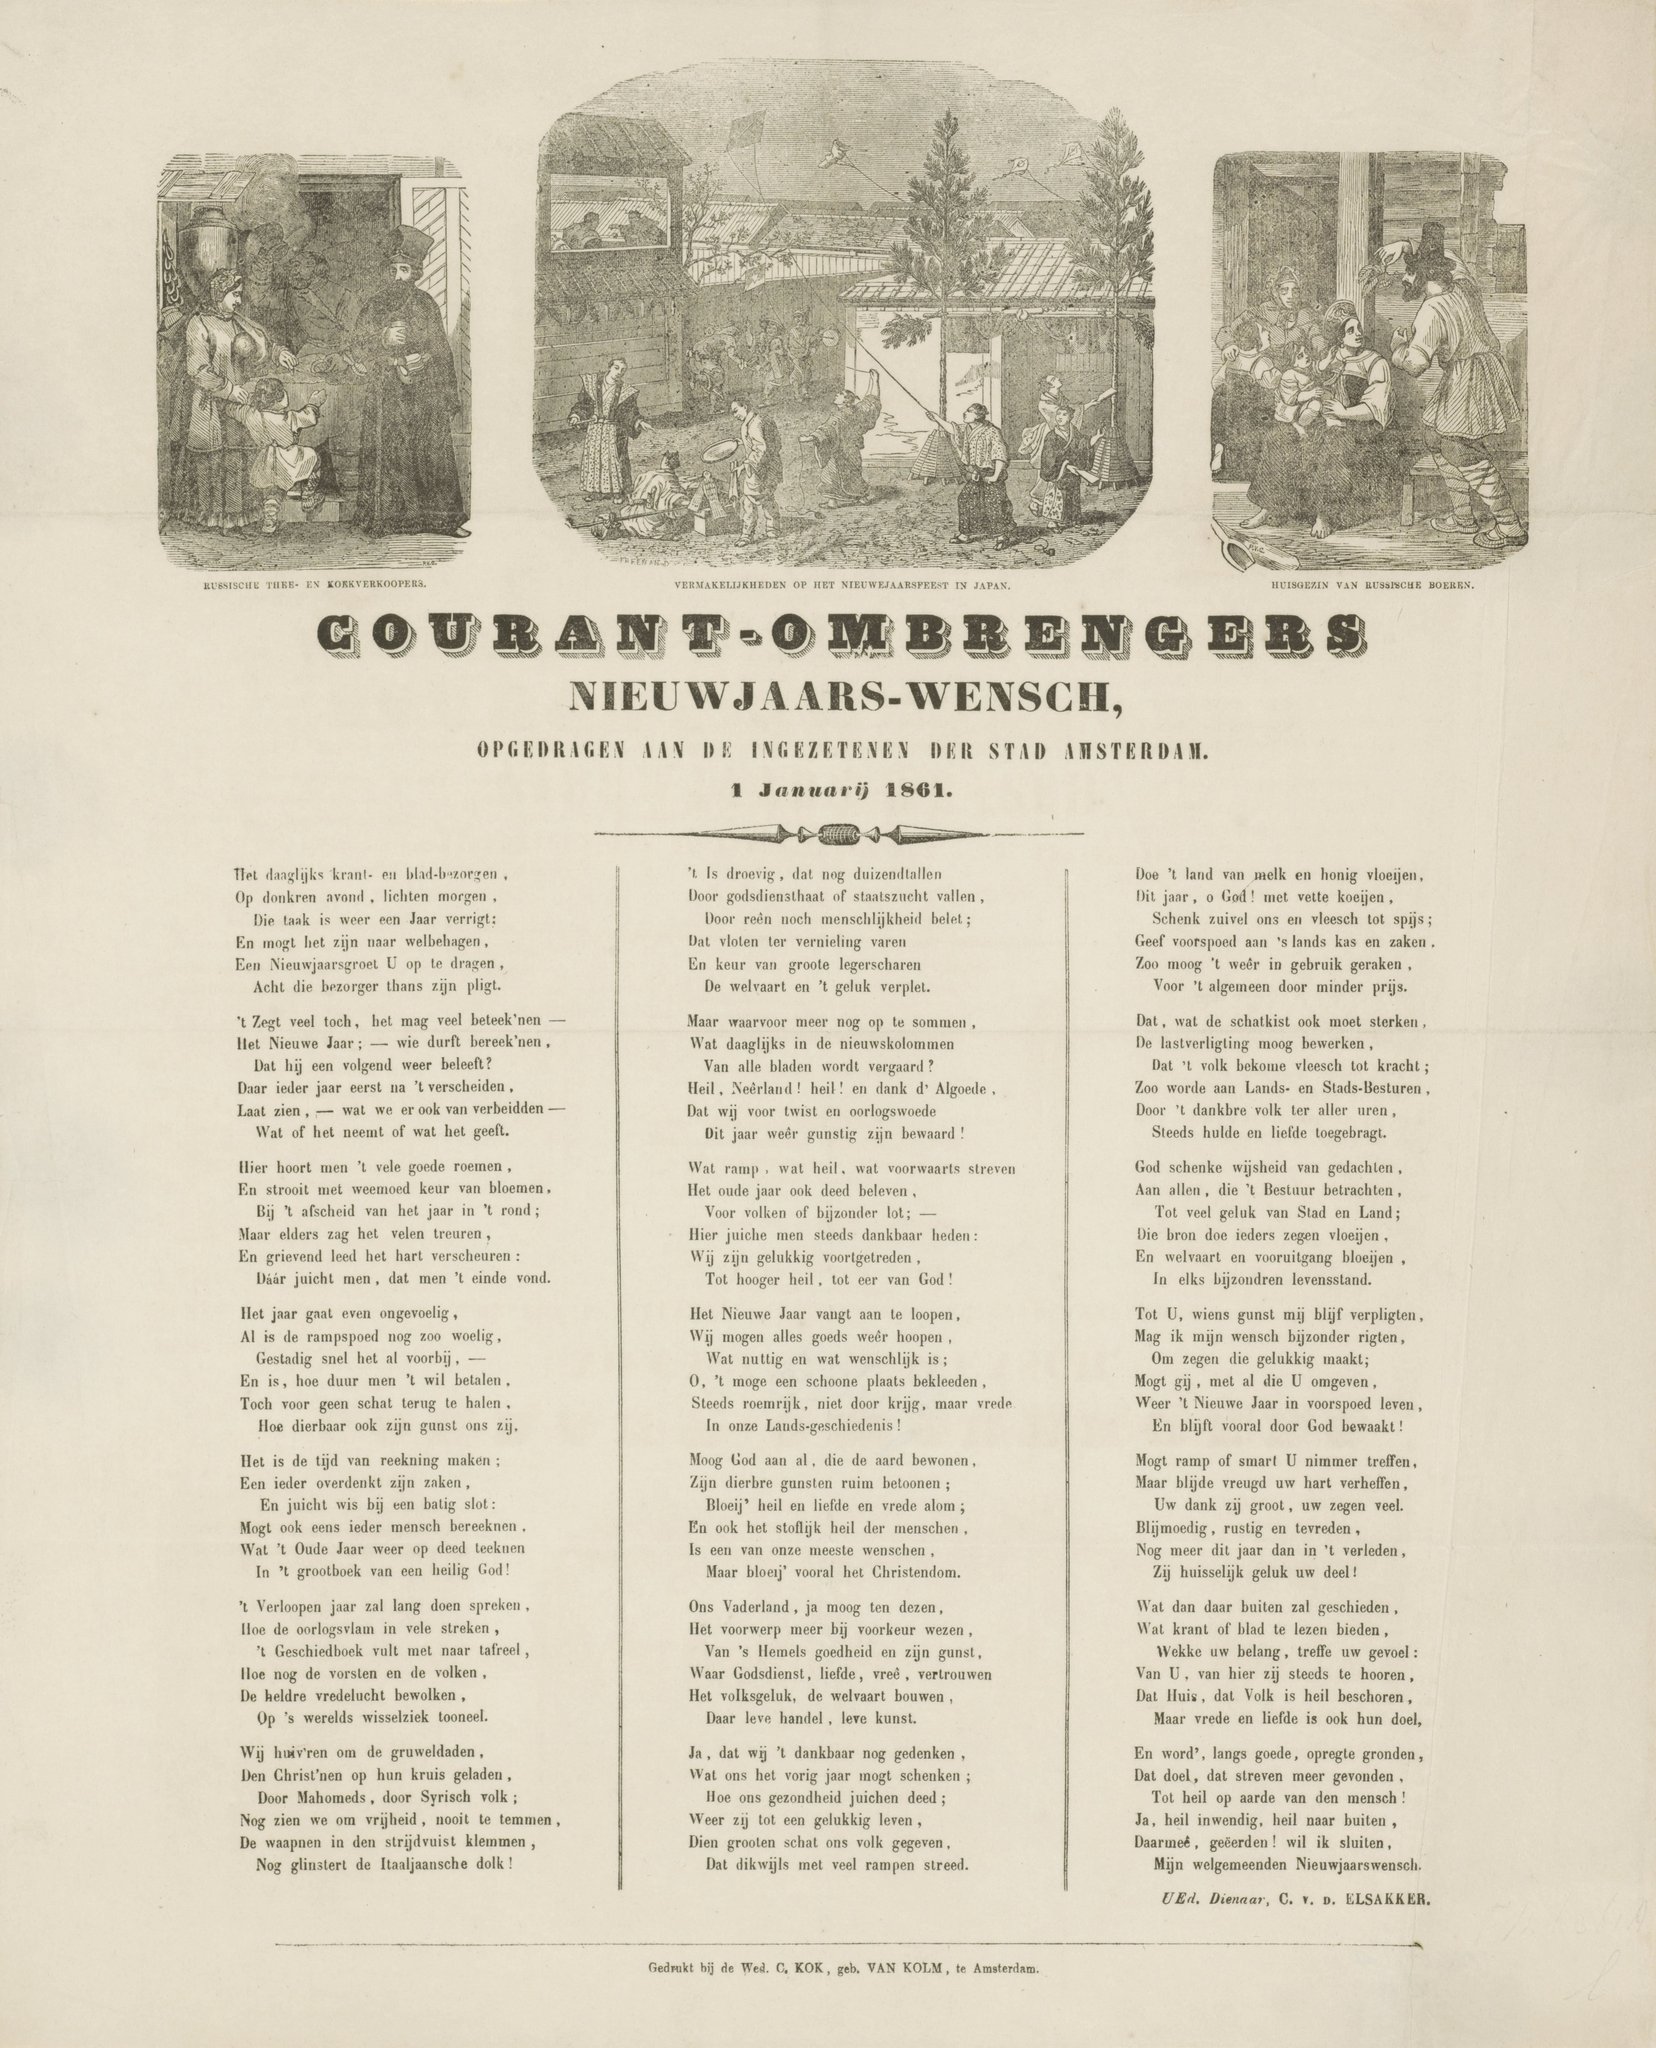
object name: new year card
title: Nieuwjaarswens van de Amsterdamse courantombrengers voor het jaar 1861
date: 1860-1861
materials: paper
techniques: letterpress printing, engraving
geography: amsterdam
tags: january 1 (~ festivities), tea-pot; samovar, (flying a) kite, russia, japan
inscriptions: collector's mark: Lugt 2228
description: Nieuwjaarswens namens de ombrengers van couranten (krantenbezorgers) te Amsterdam voor het jaar 1861. Bovenaan drie vignetten aan boeken ontleend, met centraal een nieuwjaarsfeest in Japan, links Russische thee- en koffieverkopers, rechts een Russische boerenfamilie. Onderaan een gedicht in drie kolommen. Van de courantombrenger: C. v.d. Elsakker.